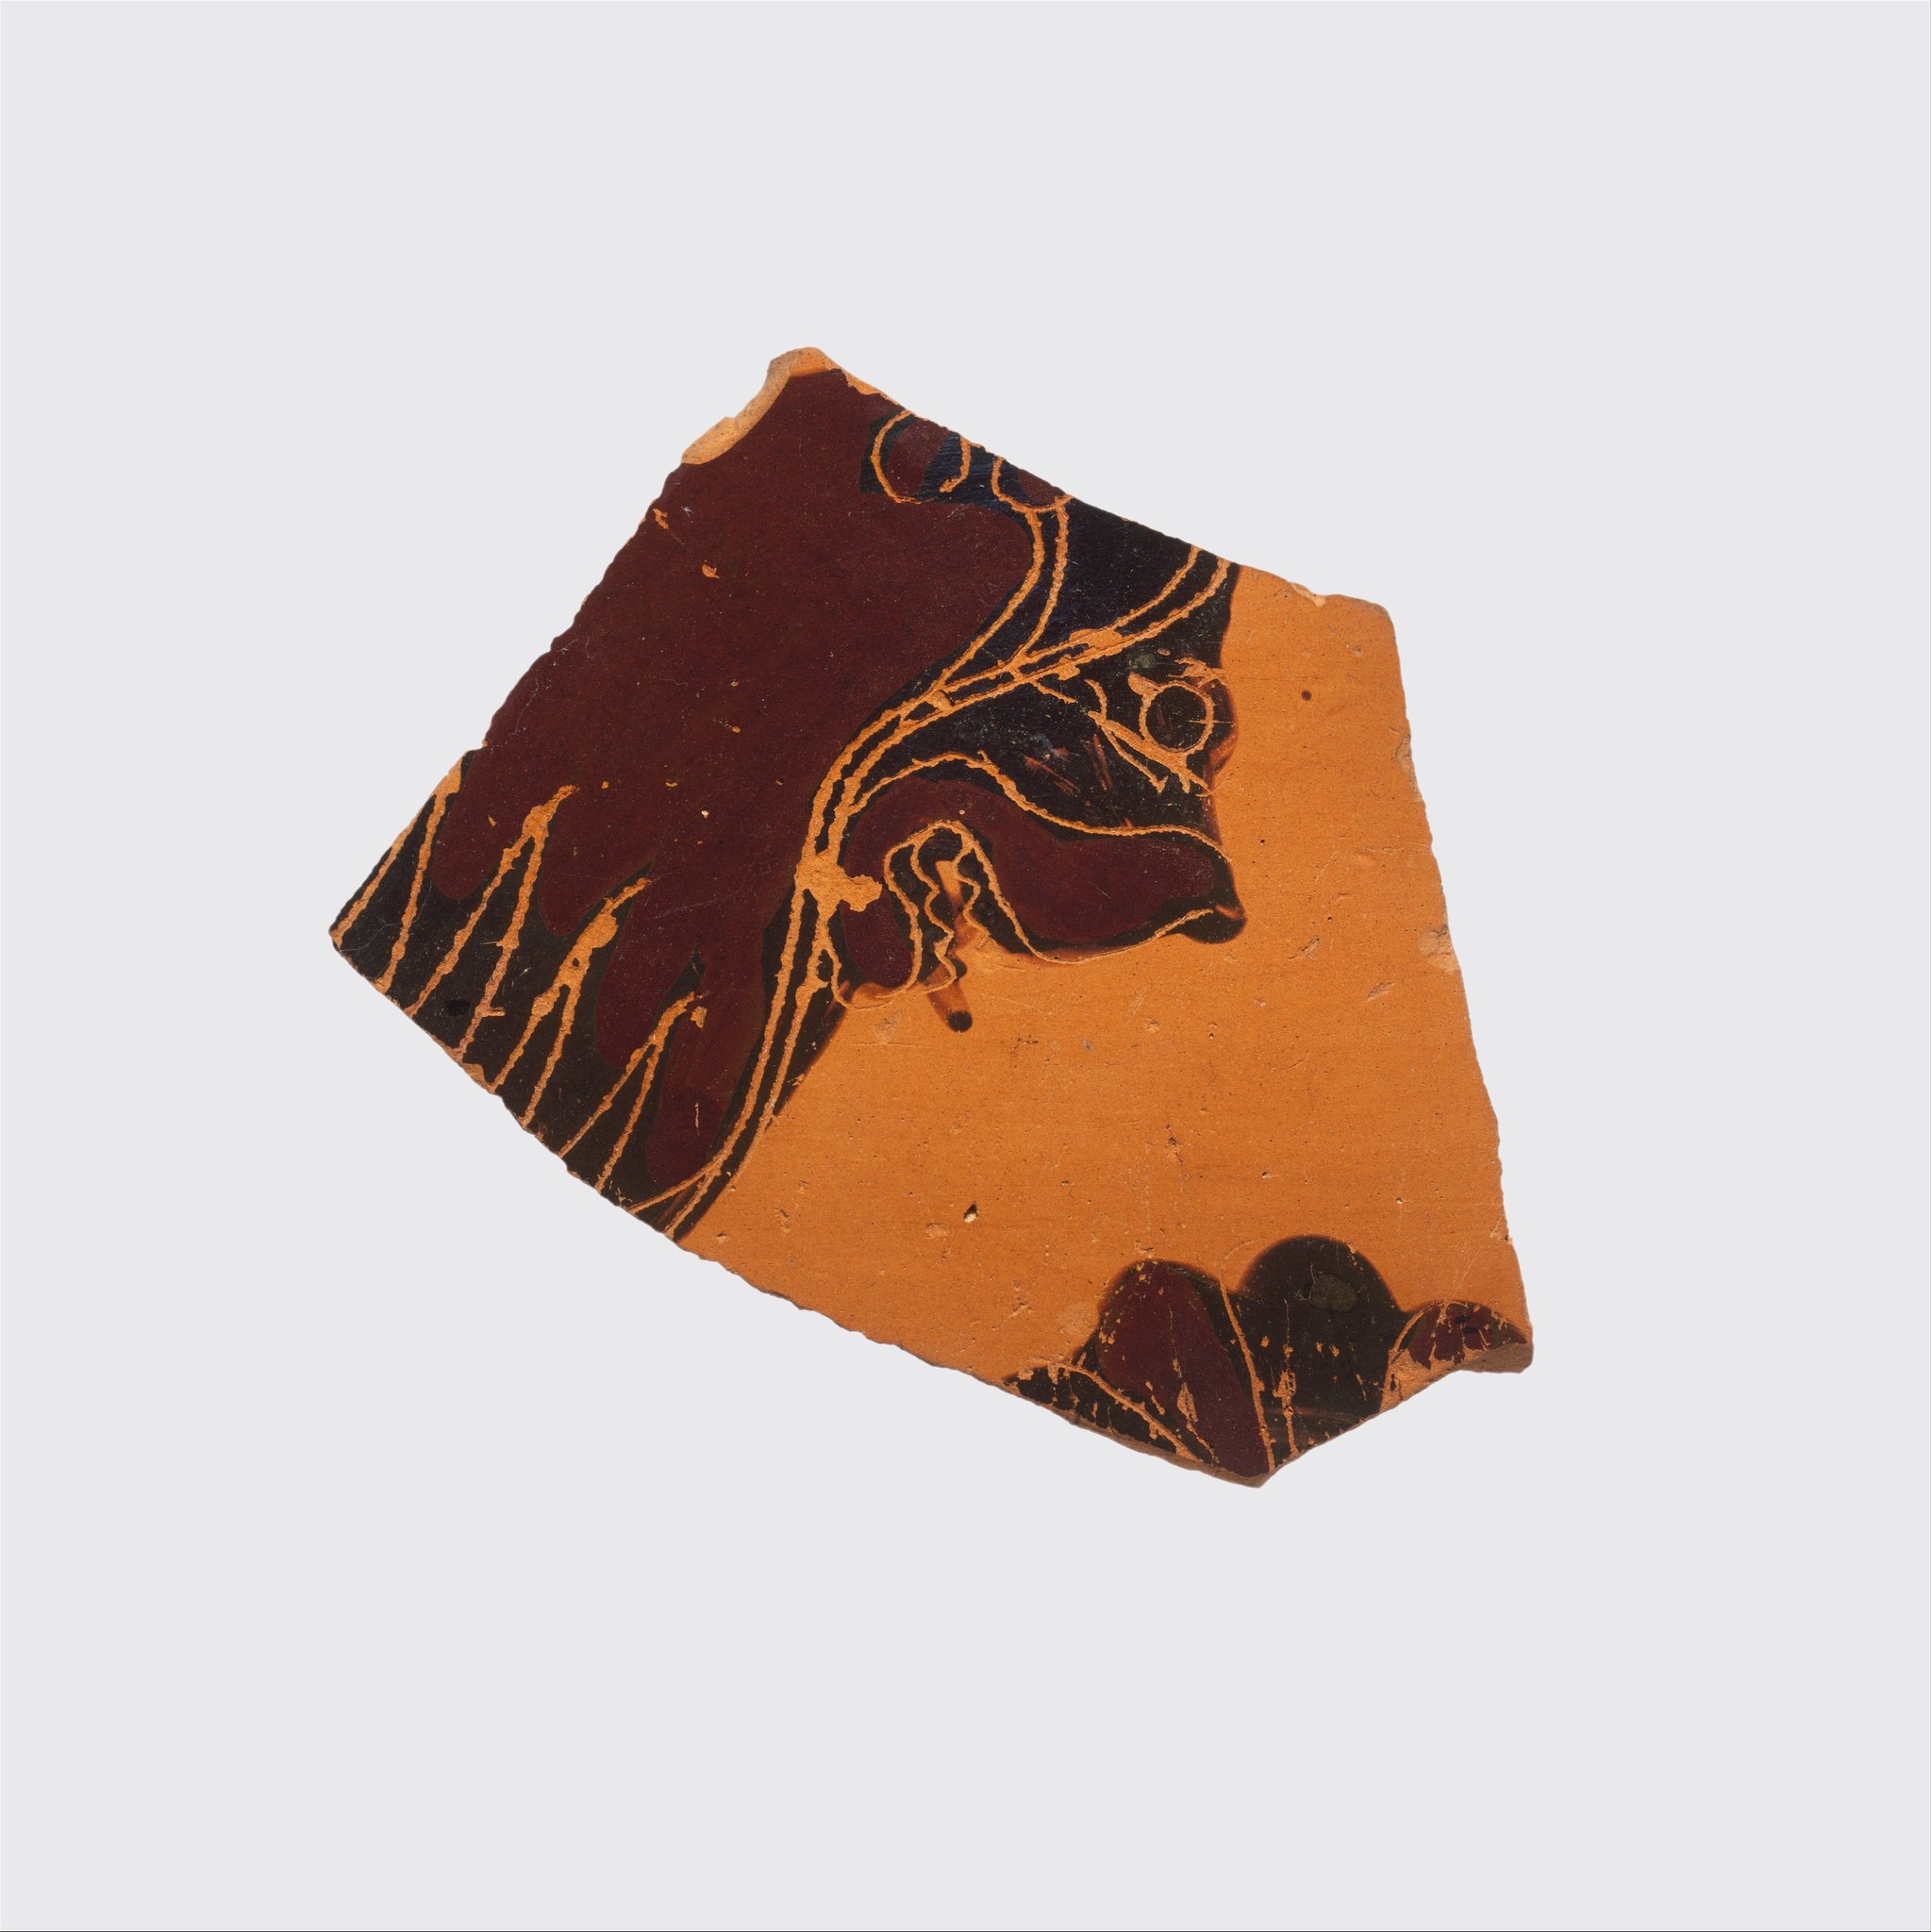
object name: olpe fragment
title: Fragment of a terracotta oinochoe: olpe (jug)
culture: greek, attic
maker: gorgon painter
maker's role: artist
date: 580 BCE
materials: terracotta